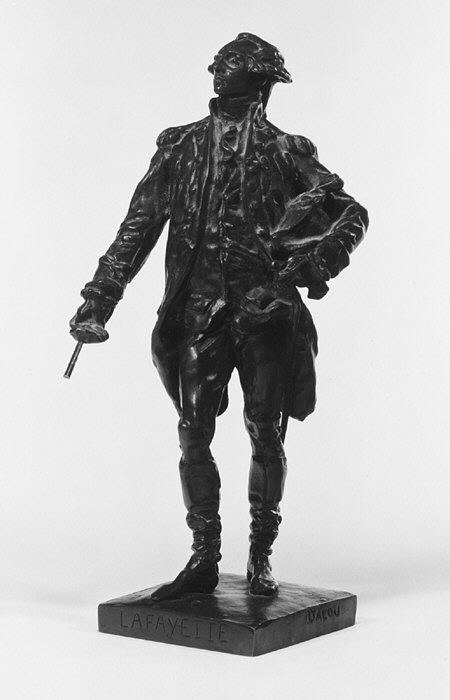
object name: statuette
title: Marquis de Lafayette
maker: aimé-jules dalou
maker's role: artist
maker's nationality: french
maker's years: 1838-1902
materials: bronze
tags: men,marquis de lafayette